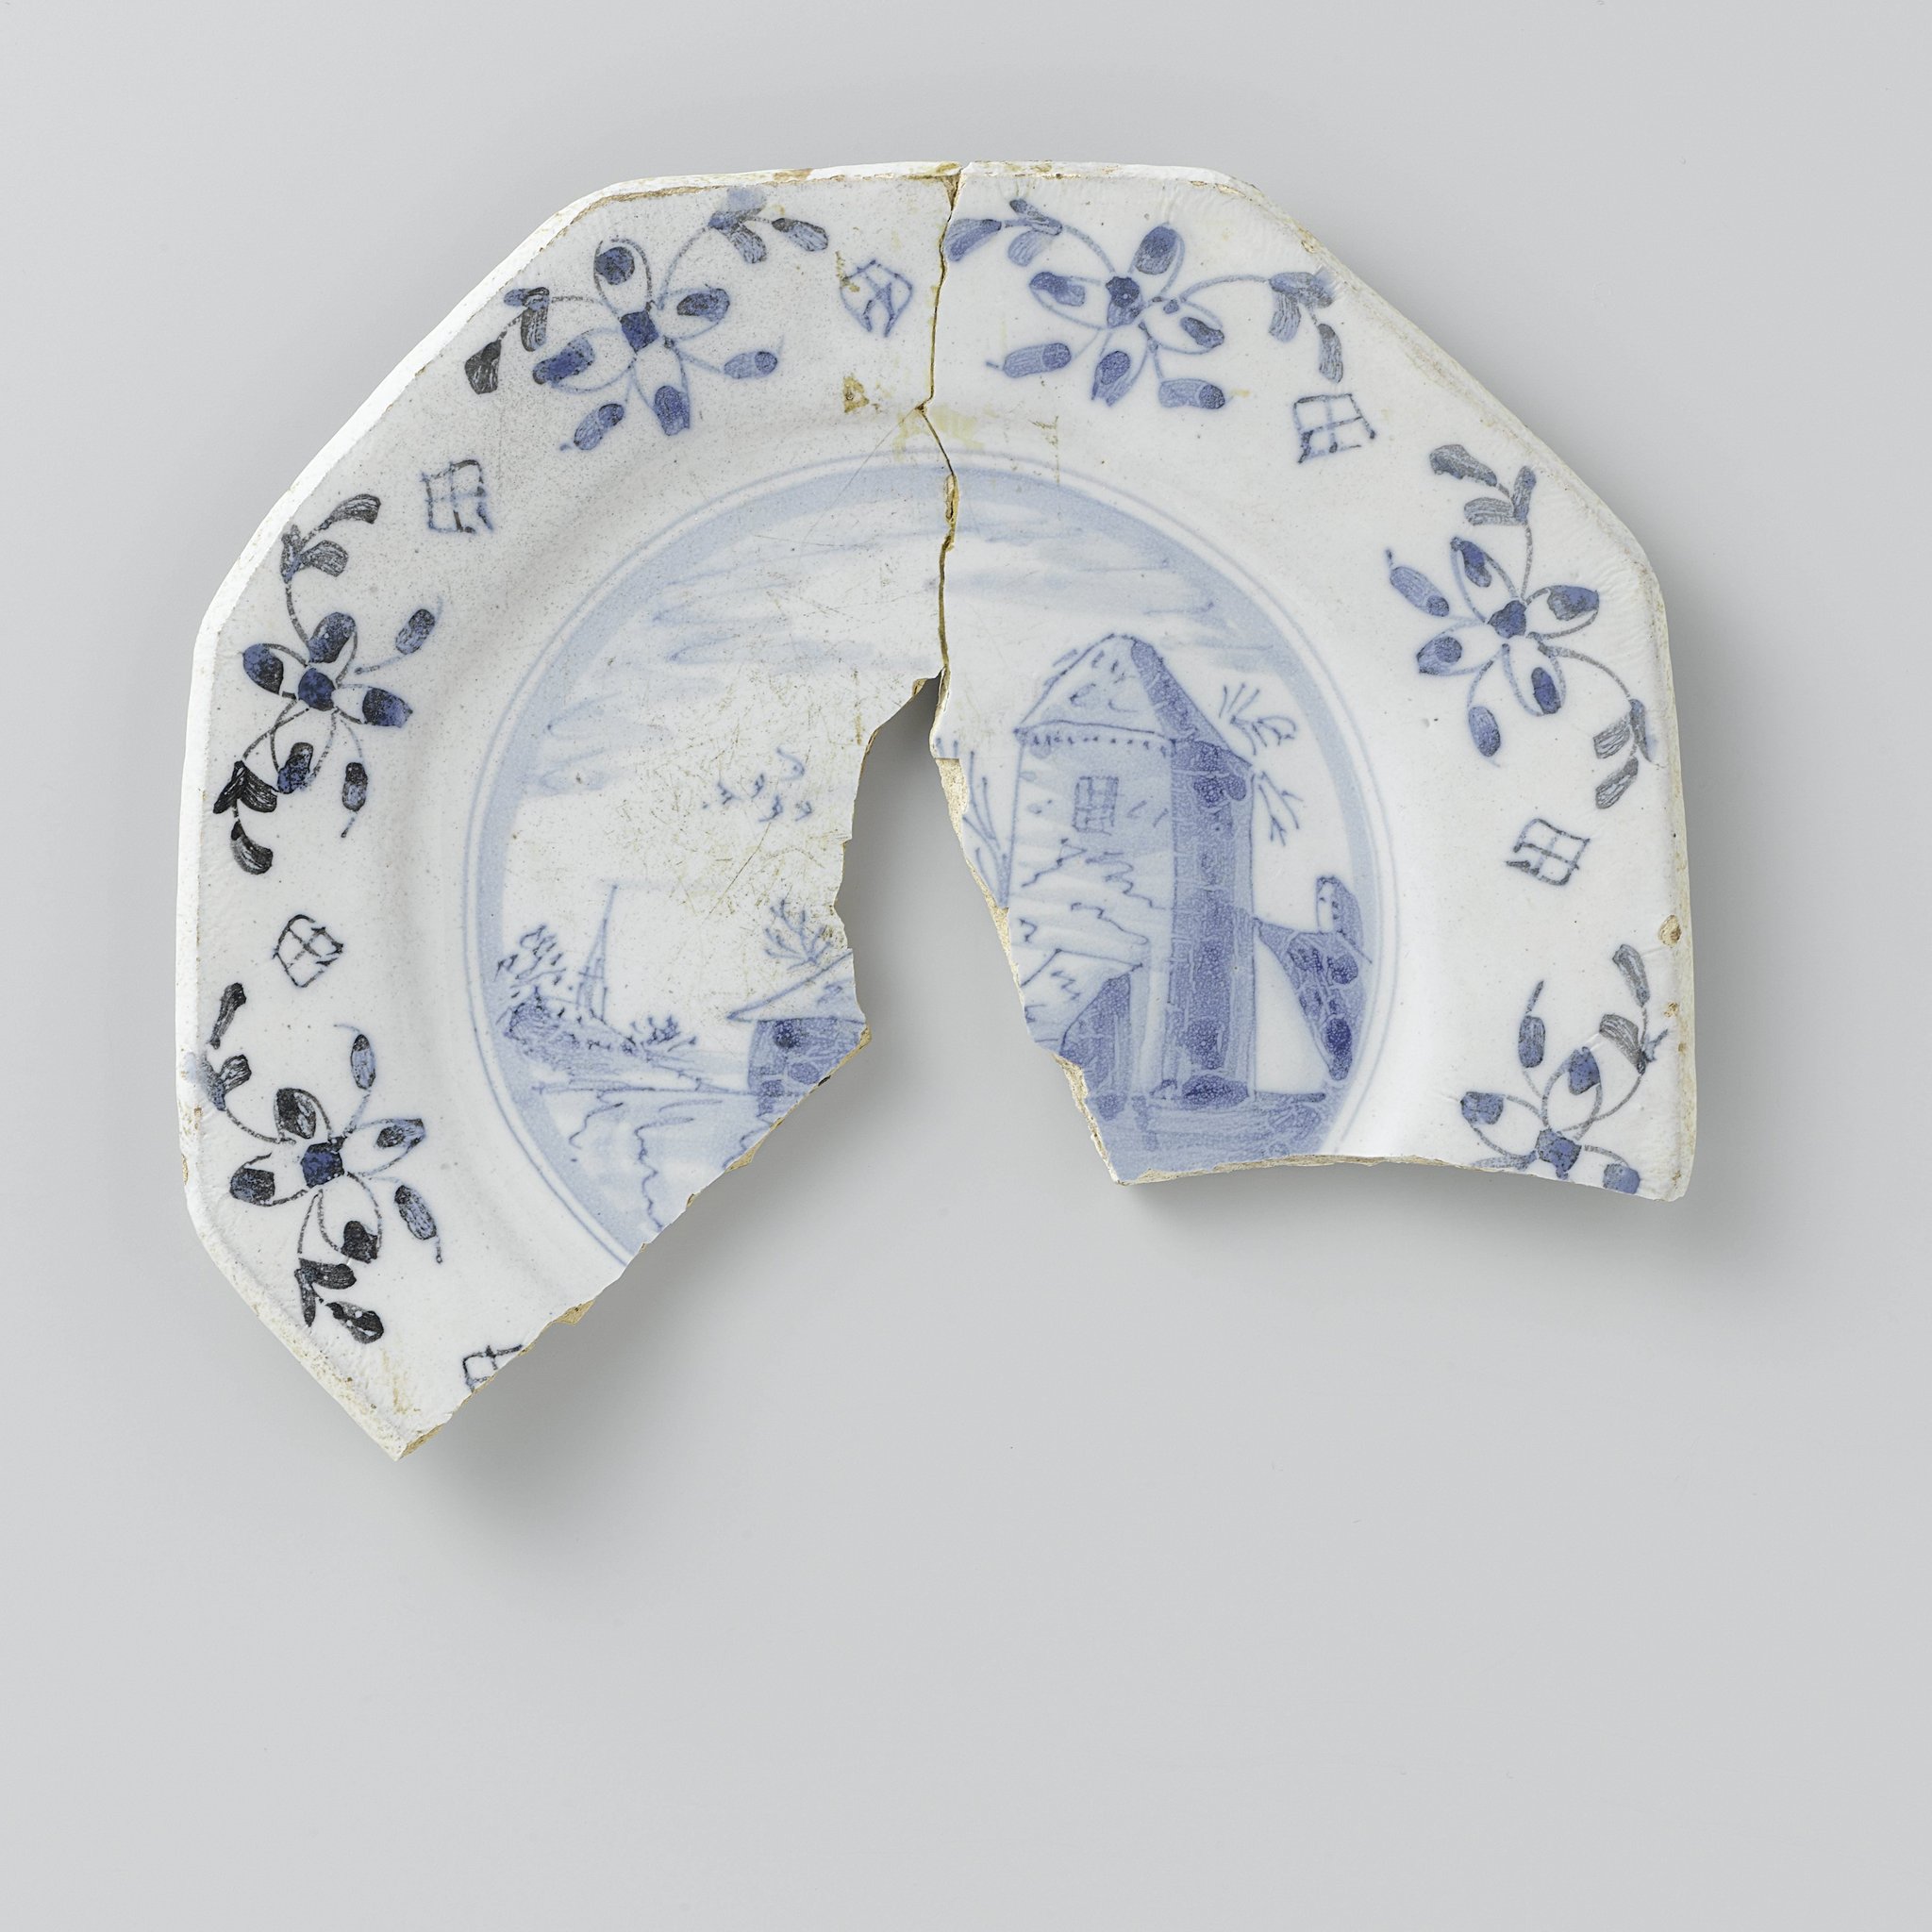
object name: sherd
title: fragmentarisch bord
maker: Anonymous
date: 1650-1670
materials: earthenware, glaze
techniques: painted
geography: delft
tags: leiden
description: fragmentarisch achthoekig bord van blauw beschilderde faience. Op het plat is een landschap met een gebouw met een toren geschilderd en op de rand vierbladige rozettenen. Het bord is een bodemvondst uit Leiden en bestaat uit twee stukken.